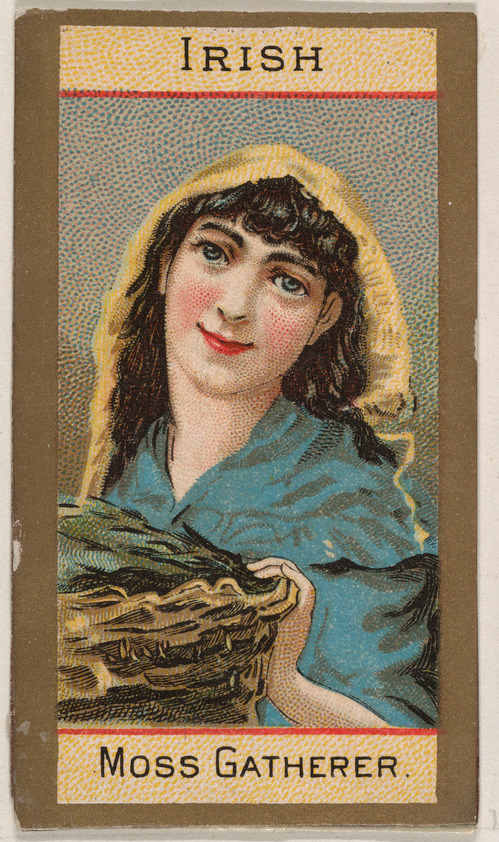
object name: print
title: Irish, Moss Gatherer, from Types of Nationalities (N240) issued by Kinney Bros.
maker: kinney brothers tobacco company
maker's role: publisher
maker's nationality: american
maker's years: 1869-2011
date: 1890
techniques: color lithograph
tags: women